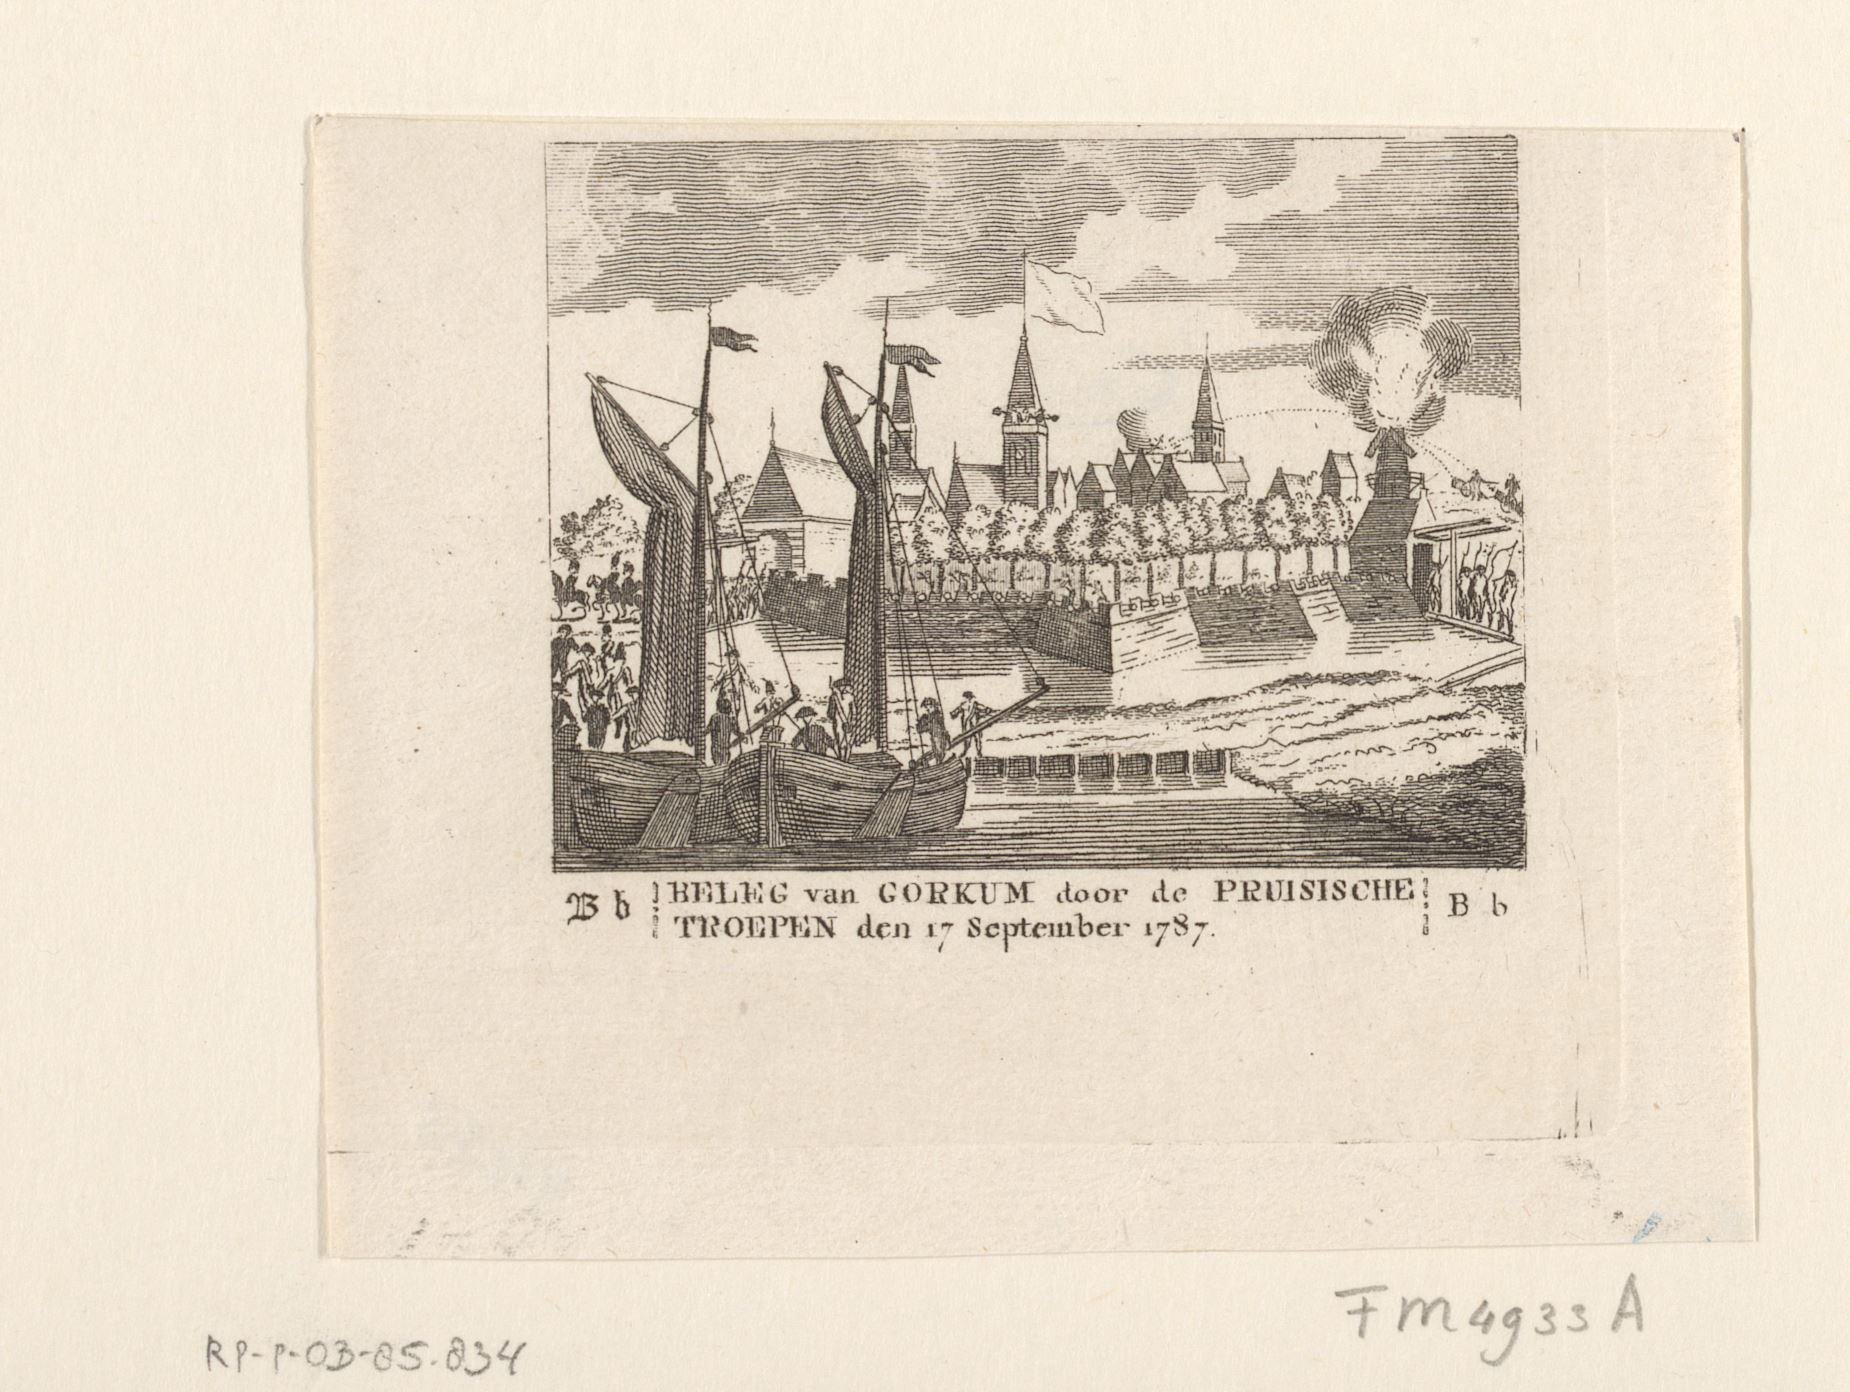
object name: print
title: Beleg van Gorkum door de Pruisische Troepen den 17 Sepetember 1787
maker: Anonymous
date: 1787-1790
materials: paper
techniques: etching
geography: northern netherlands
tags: putting the enemy to flight - hh - being put to flight, fleeing (+ citizen soldiery, civil guard, citizen militia)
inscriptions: collector's mark: Lugt 2228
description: Gebruikt als illustratie in: Vorstelyke koninglyke en princelyke atlas, en dagboek van Nederlandsche gebeurtenissen, in de laatste jaaren voorgevallen. En oprecht vaderlandsch (...) A.B. boek. Amsterdam: Willem Coertse, [1790].